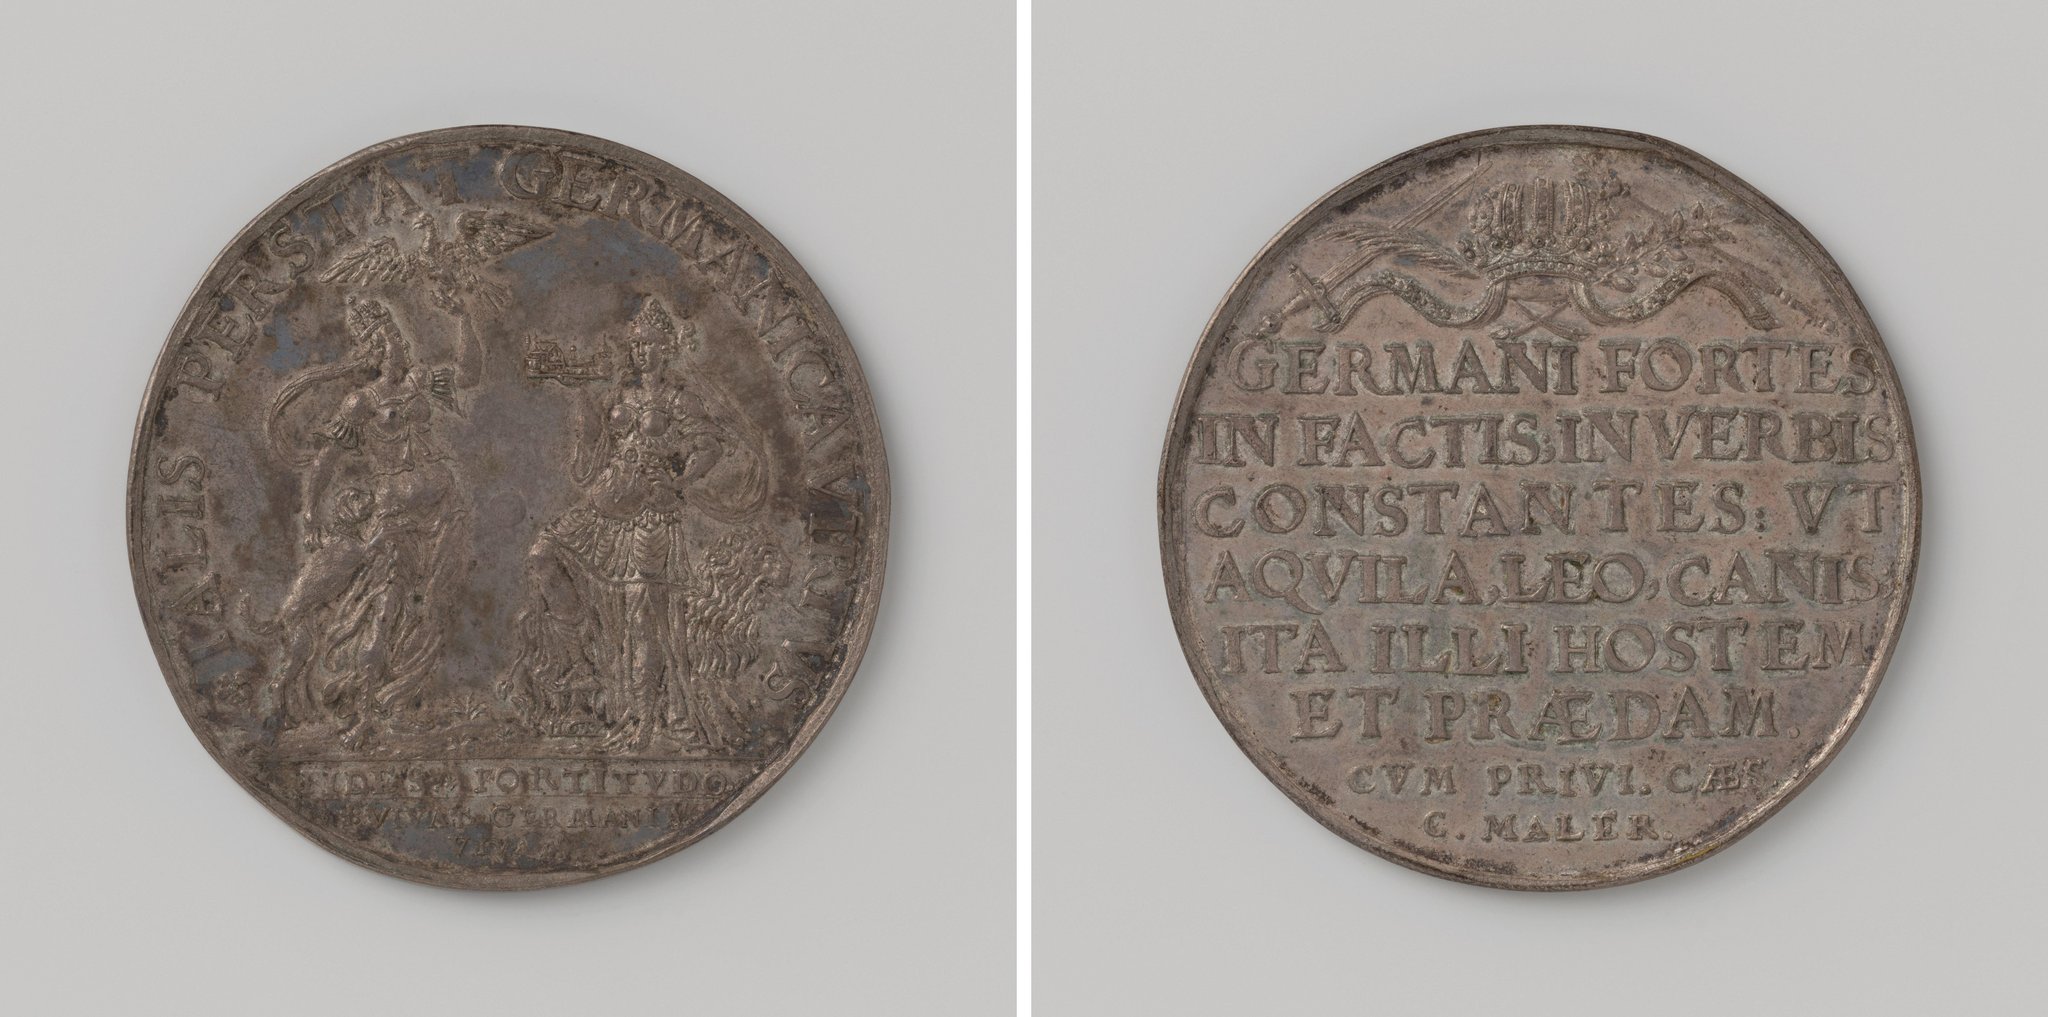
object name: history medal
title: Eerste eeuwfeest van de Reformatie door Martin Luther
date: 1617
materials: silver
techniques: striking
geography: nuremberg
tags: priest, martin luther